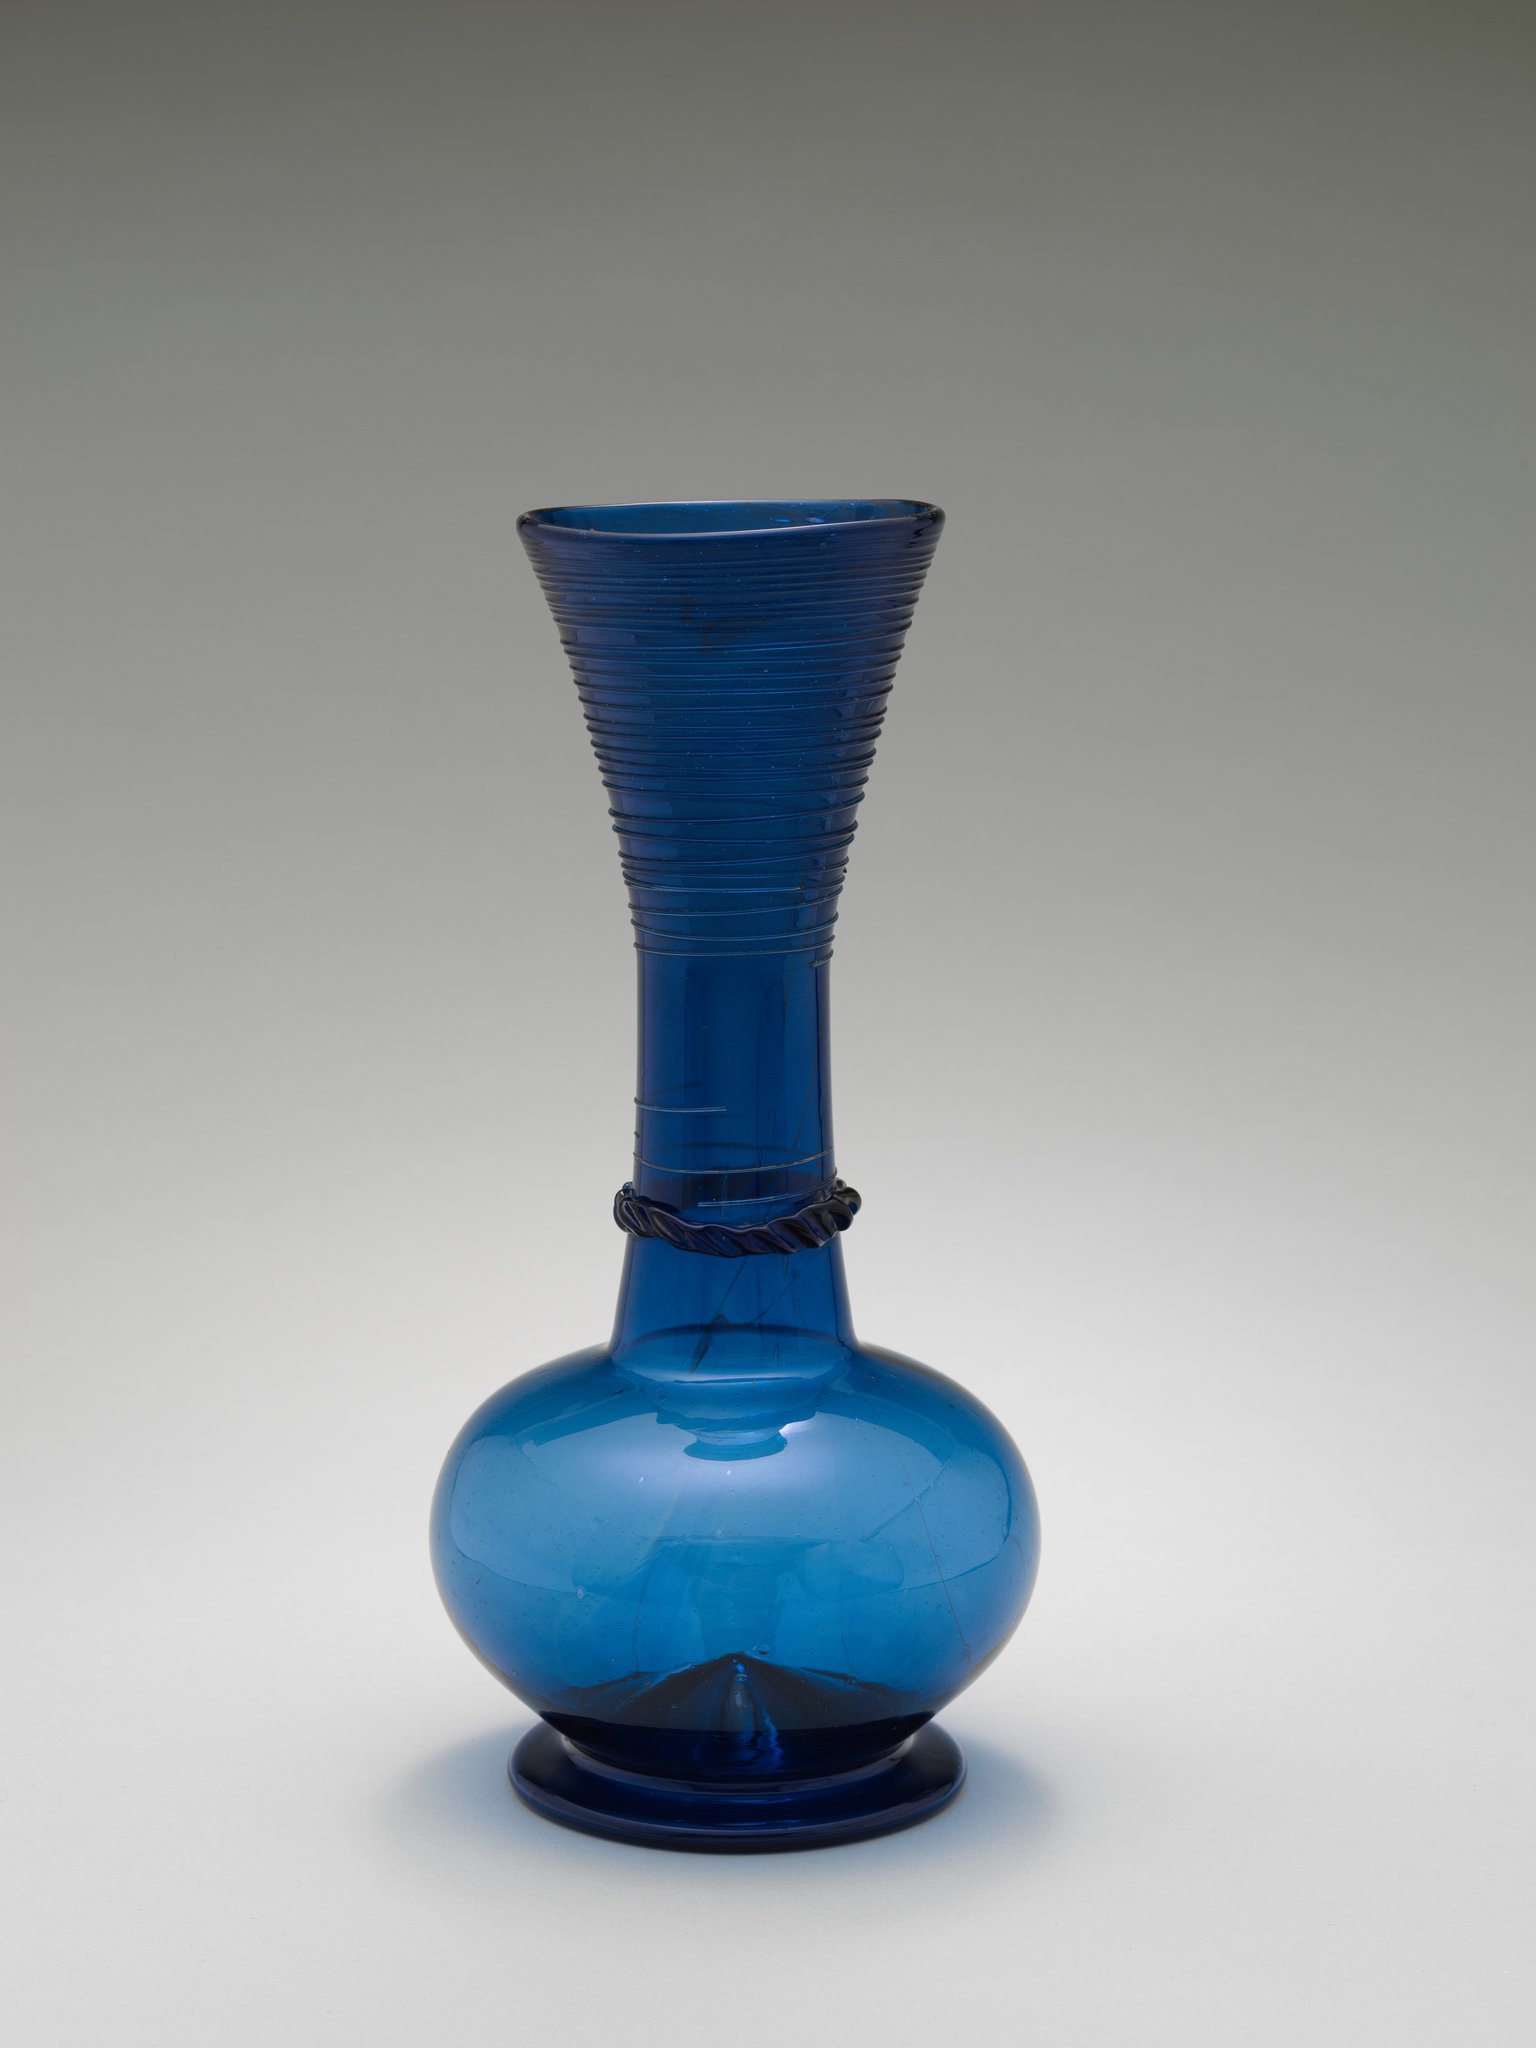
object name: bottle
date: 1701-1900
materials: glass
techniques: glassblowing, tooling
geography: iran